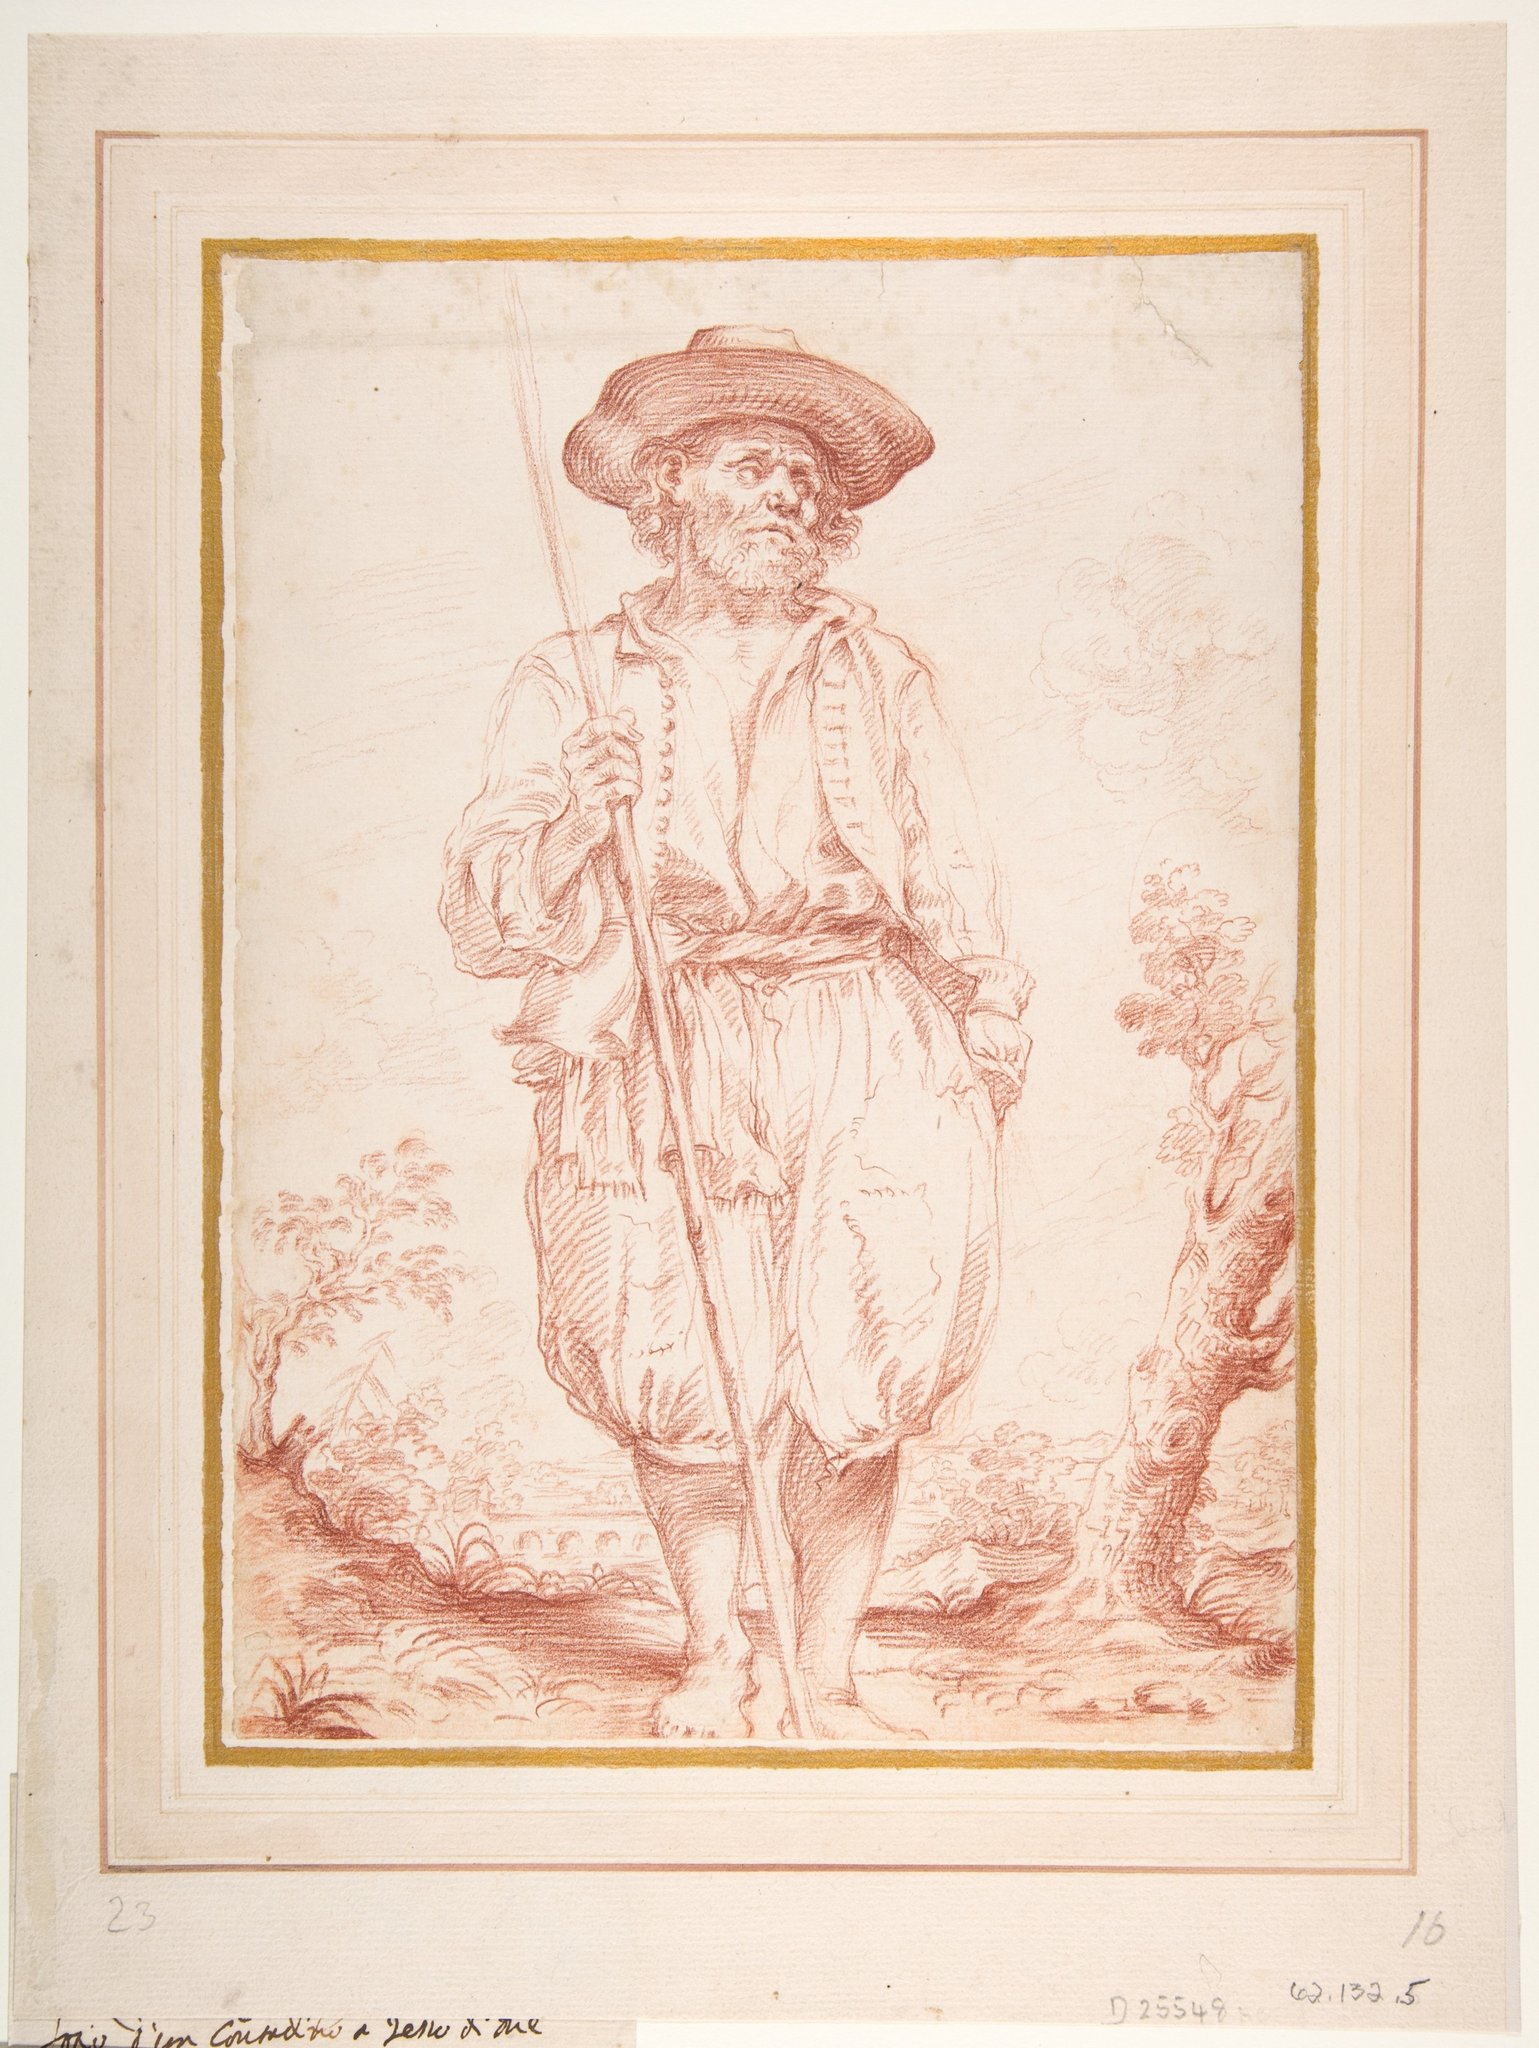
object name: drawing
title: Standing Countryman Holding a Staff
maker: giovan gioseffo dal sole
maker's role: artist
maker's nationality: italian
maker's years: 1654-1719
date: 1654-1719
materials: chalk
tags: hats,men,trees